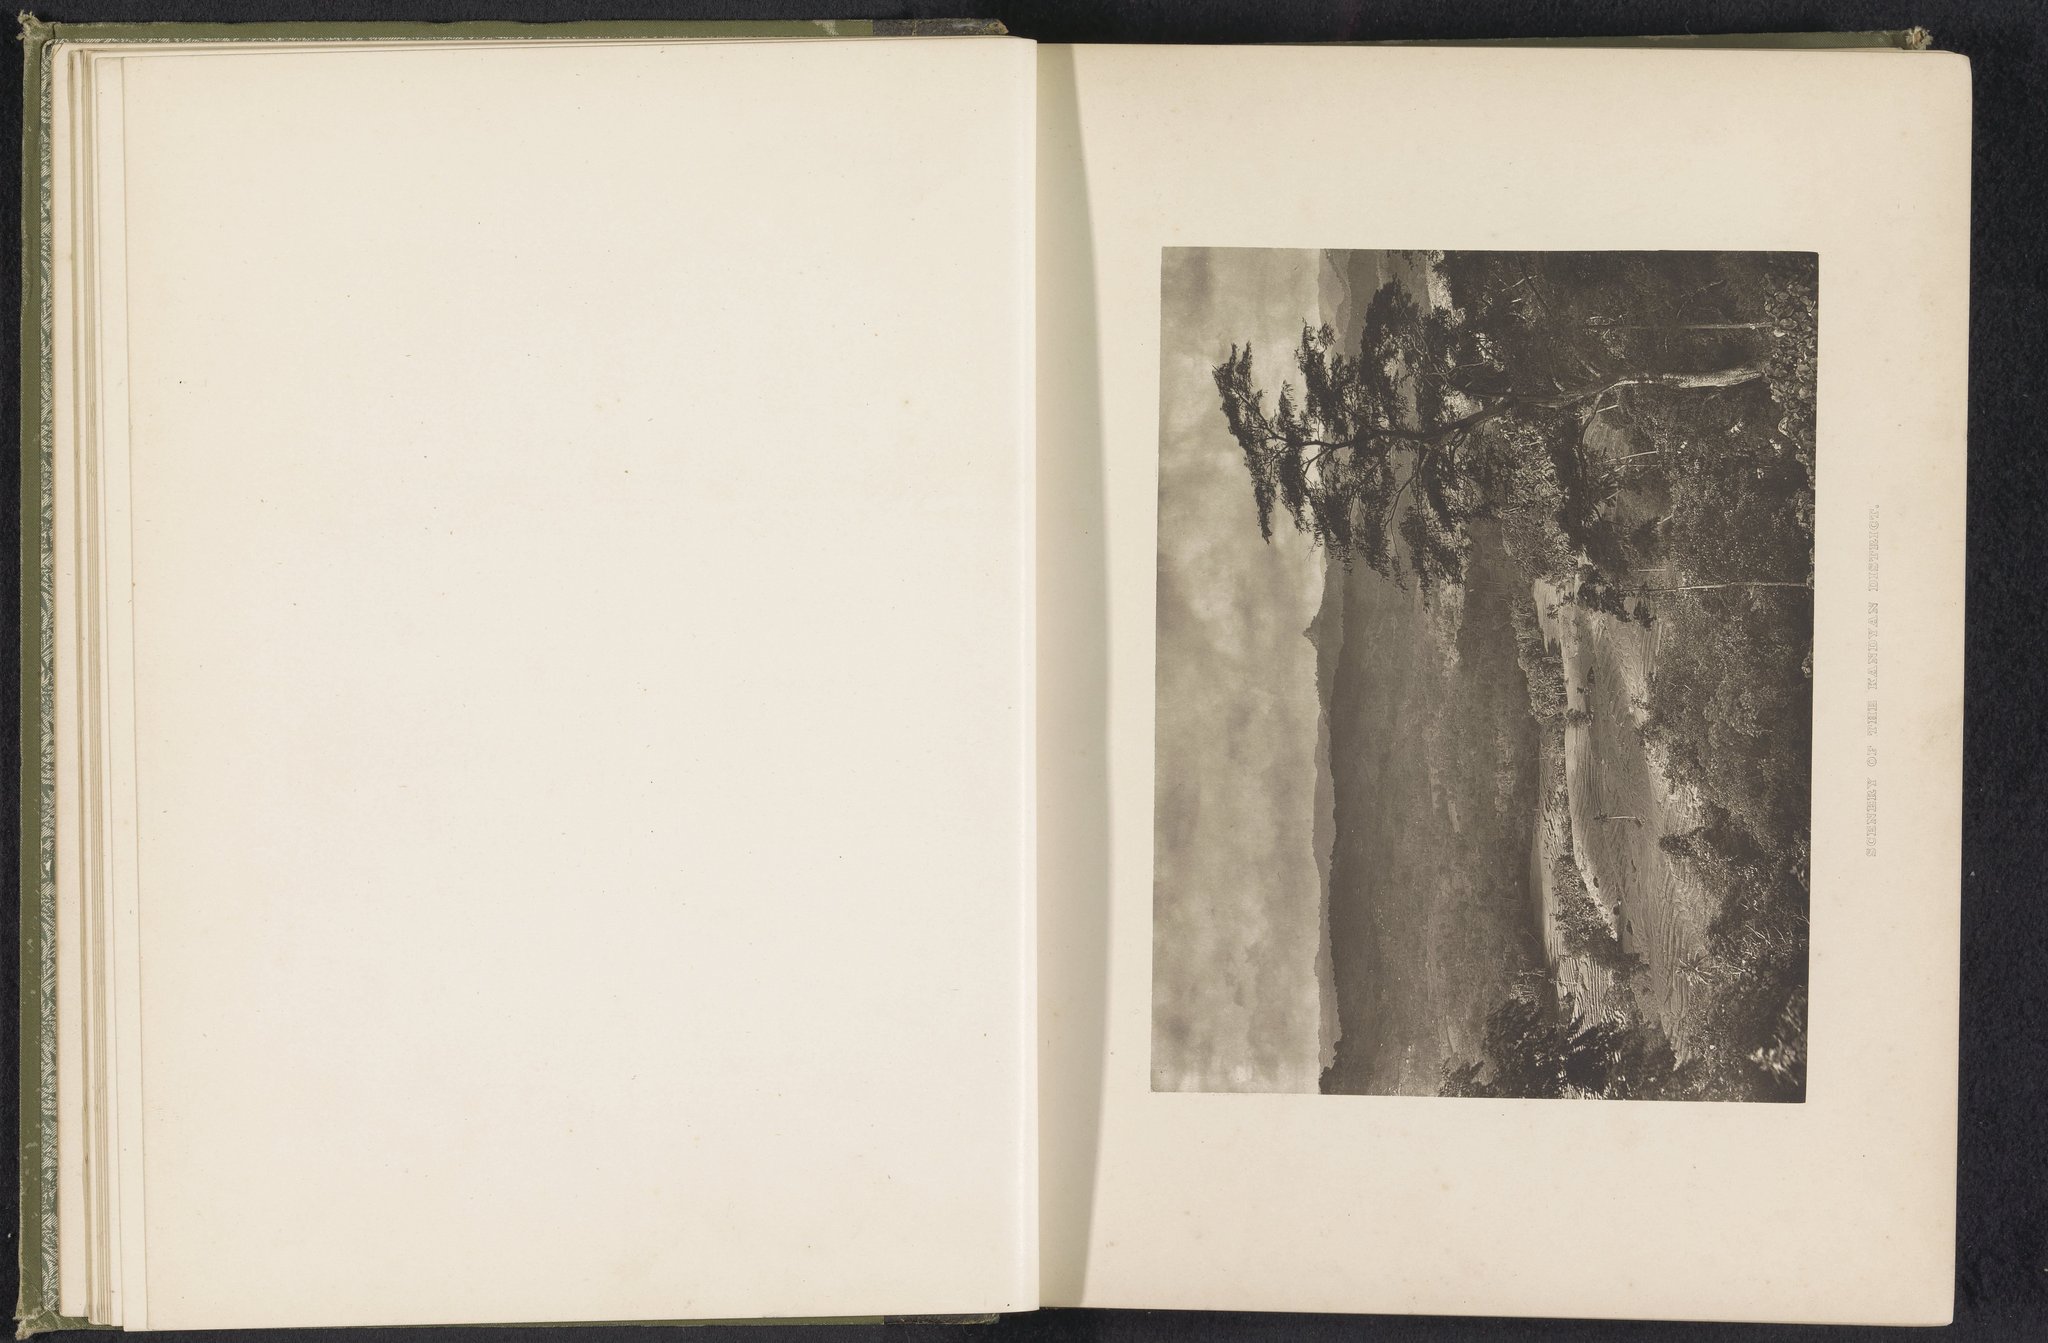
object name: photomechanical print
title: Scenery of the rural areas of Kandy district, Sri Lanka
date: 1896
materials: paper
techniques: woodburygravure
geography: kandy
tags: dale, valley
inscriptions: title: ‘SCENERY OF THE KANDYAN DISTRICT.’